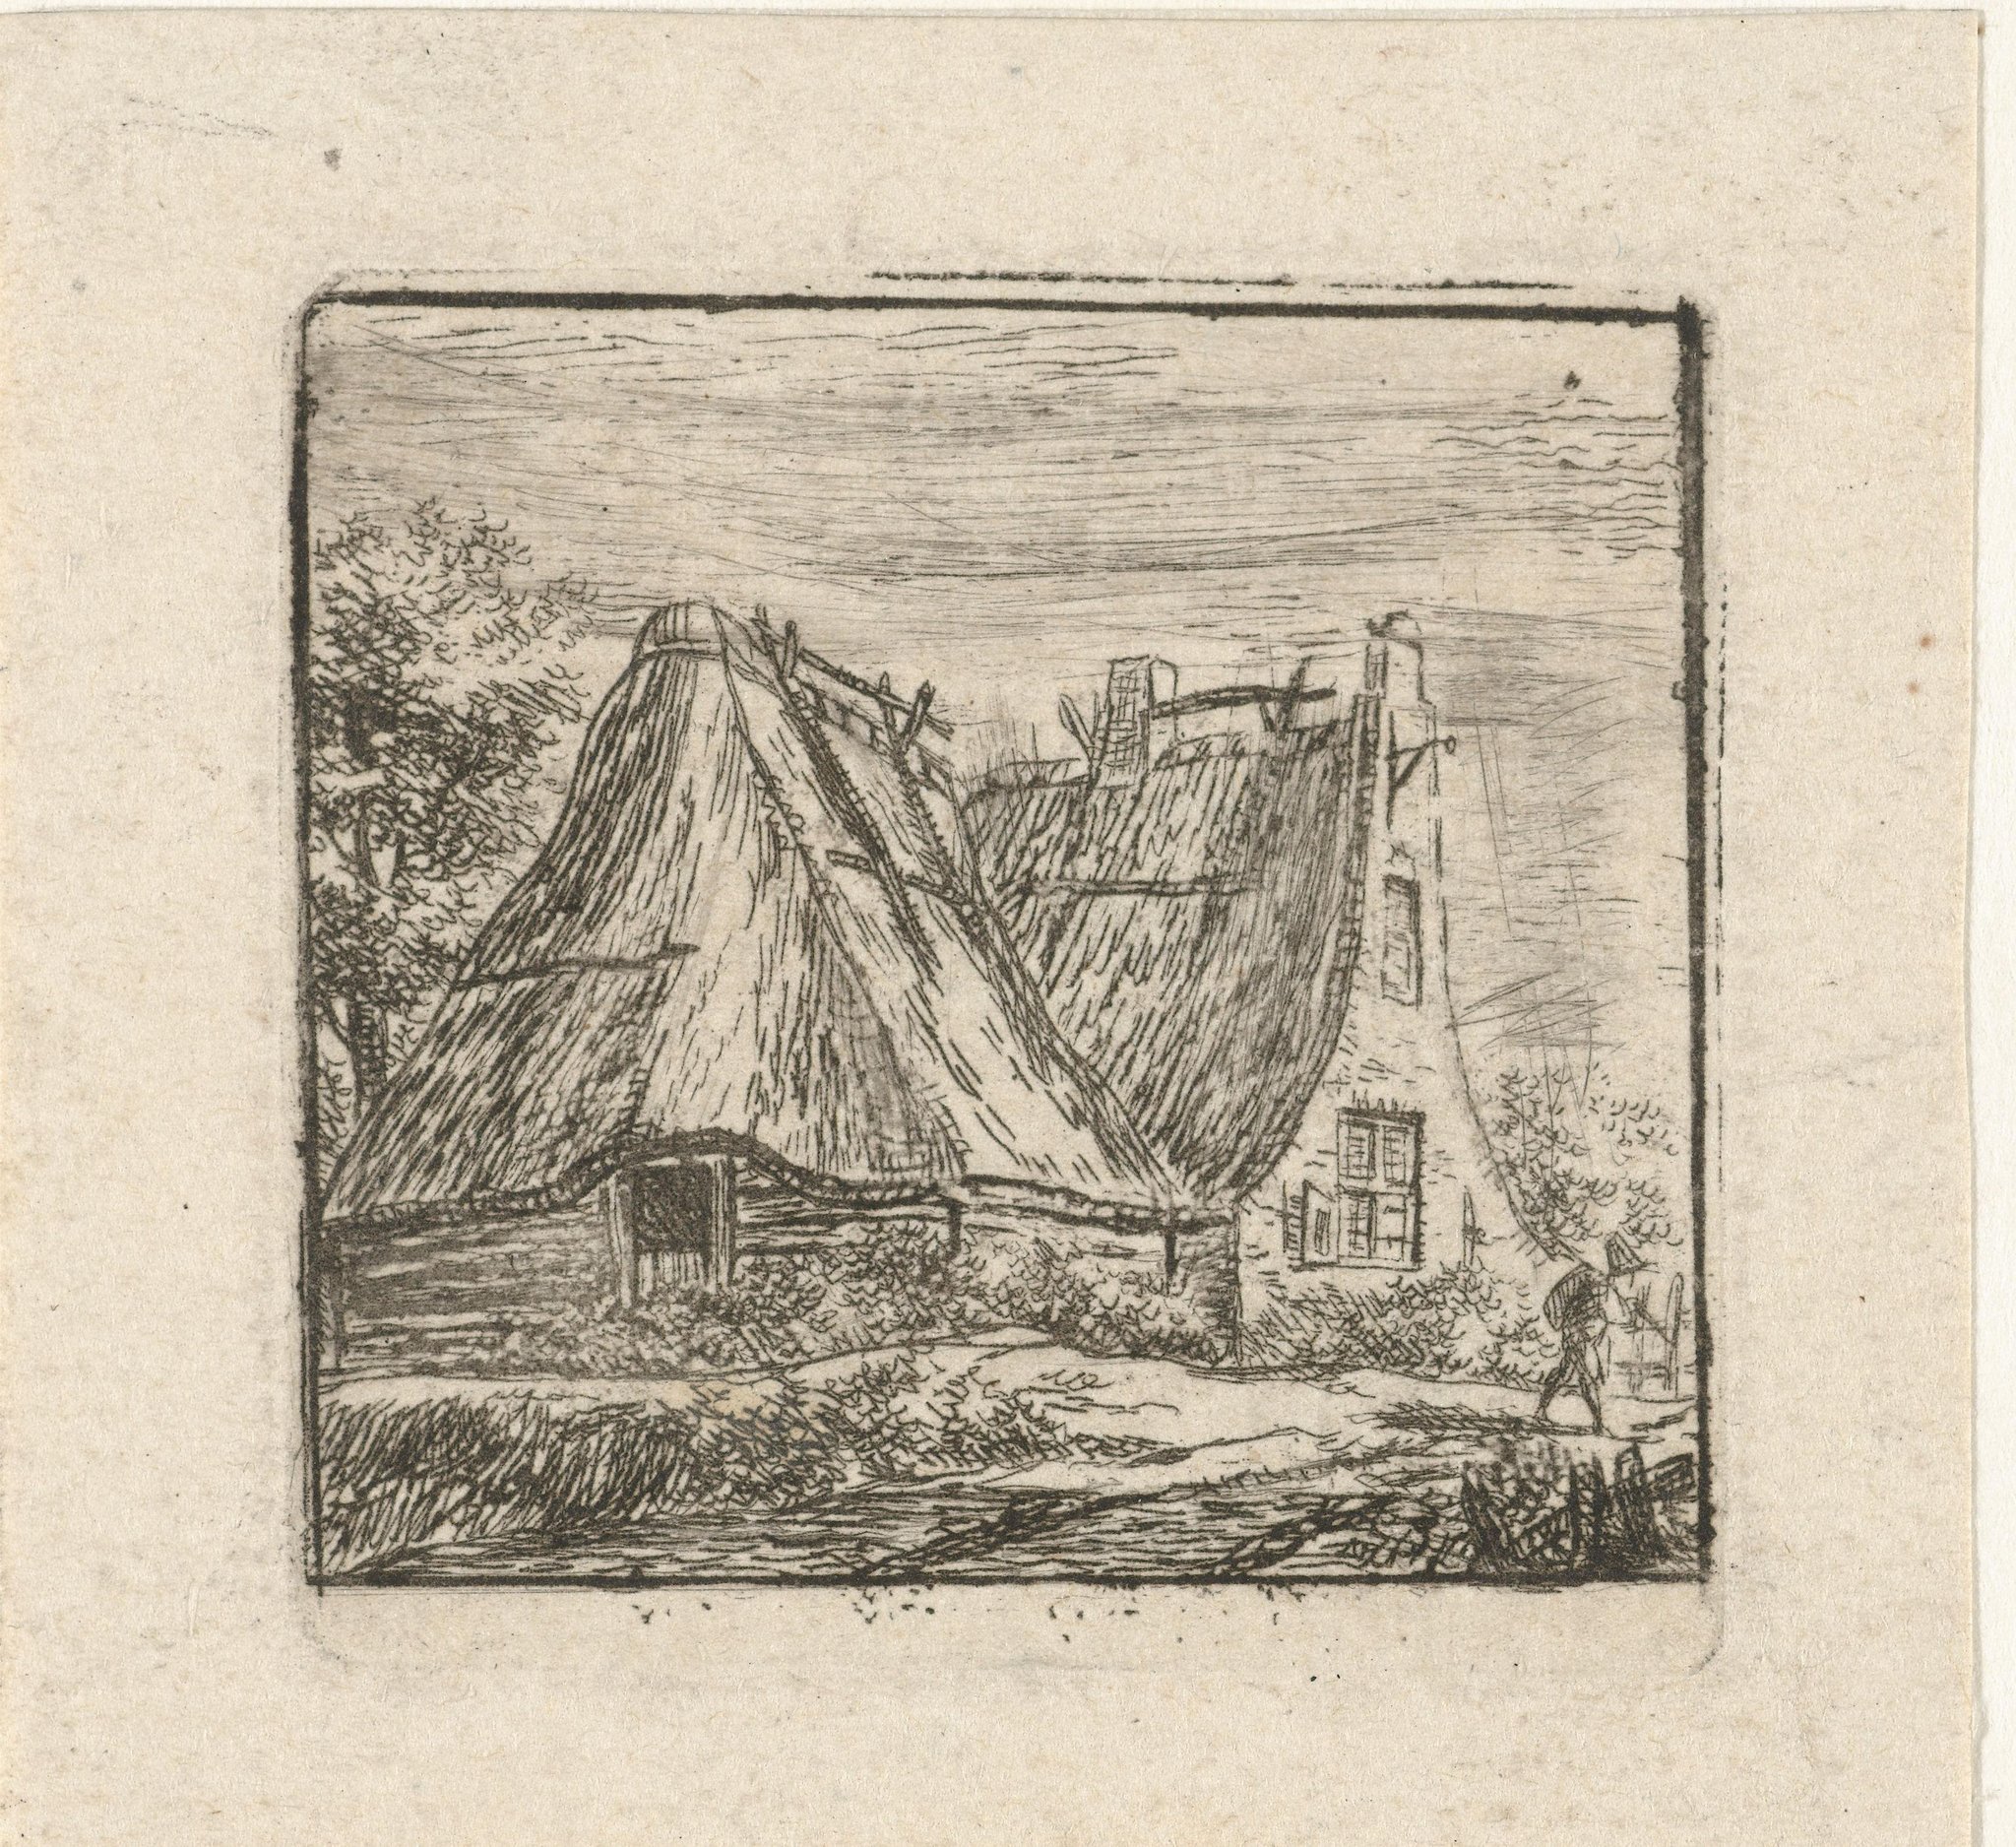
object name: print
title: Gezicht op boerderij met schuur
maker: hermanus fock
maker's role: conservator, draughtsman, painter, print maker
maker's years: 1766-1822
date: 1781-1822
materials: paper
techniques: etching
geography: amsterdam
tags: farm or solitary house in landscape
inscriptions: collector's mark: Lugt 2228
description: Rechts van de boerderij met schuur loopt een man met een hoed op het hoofd en een pak op de rug.